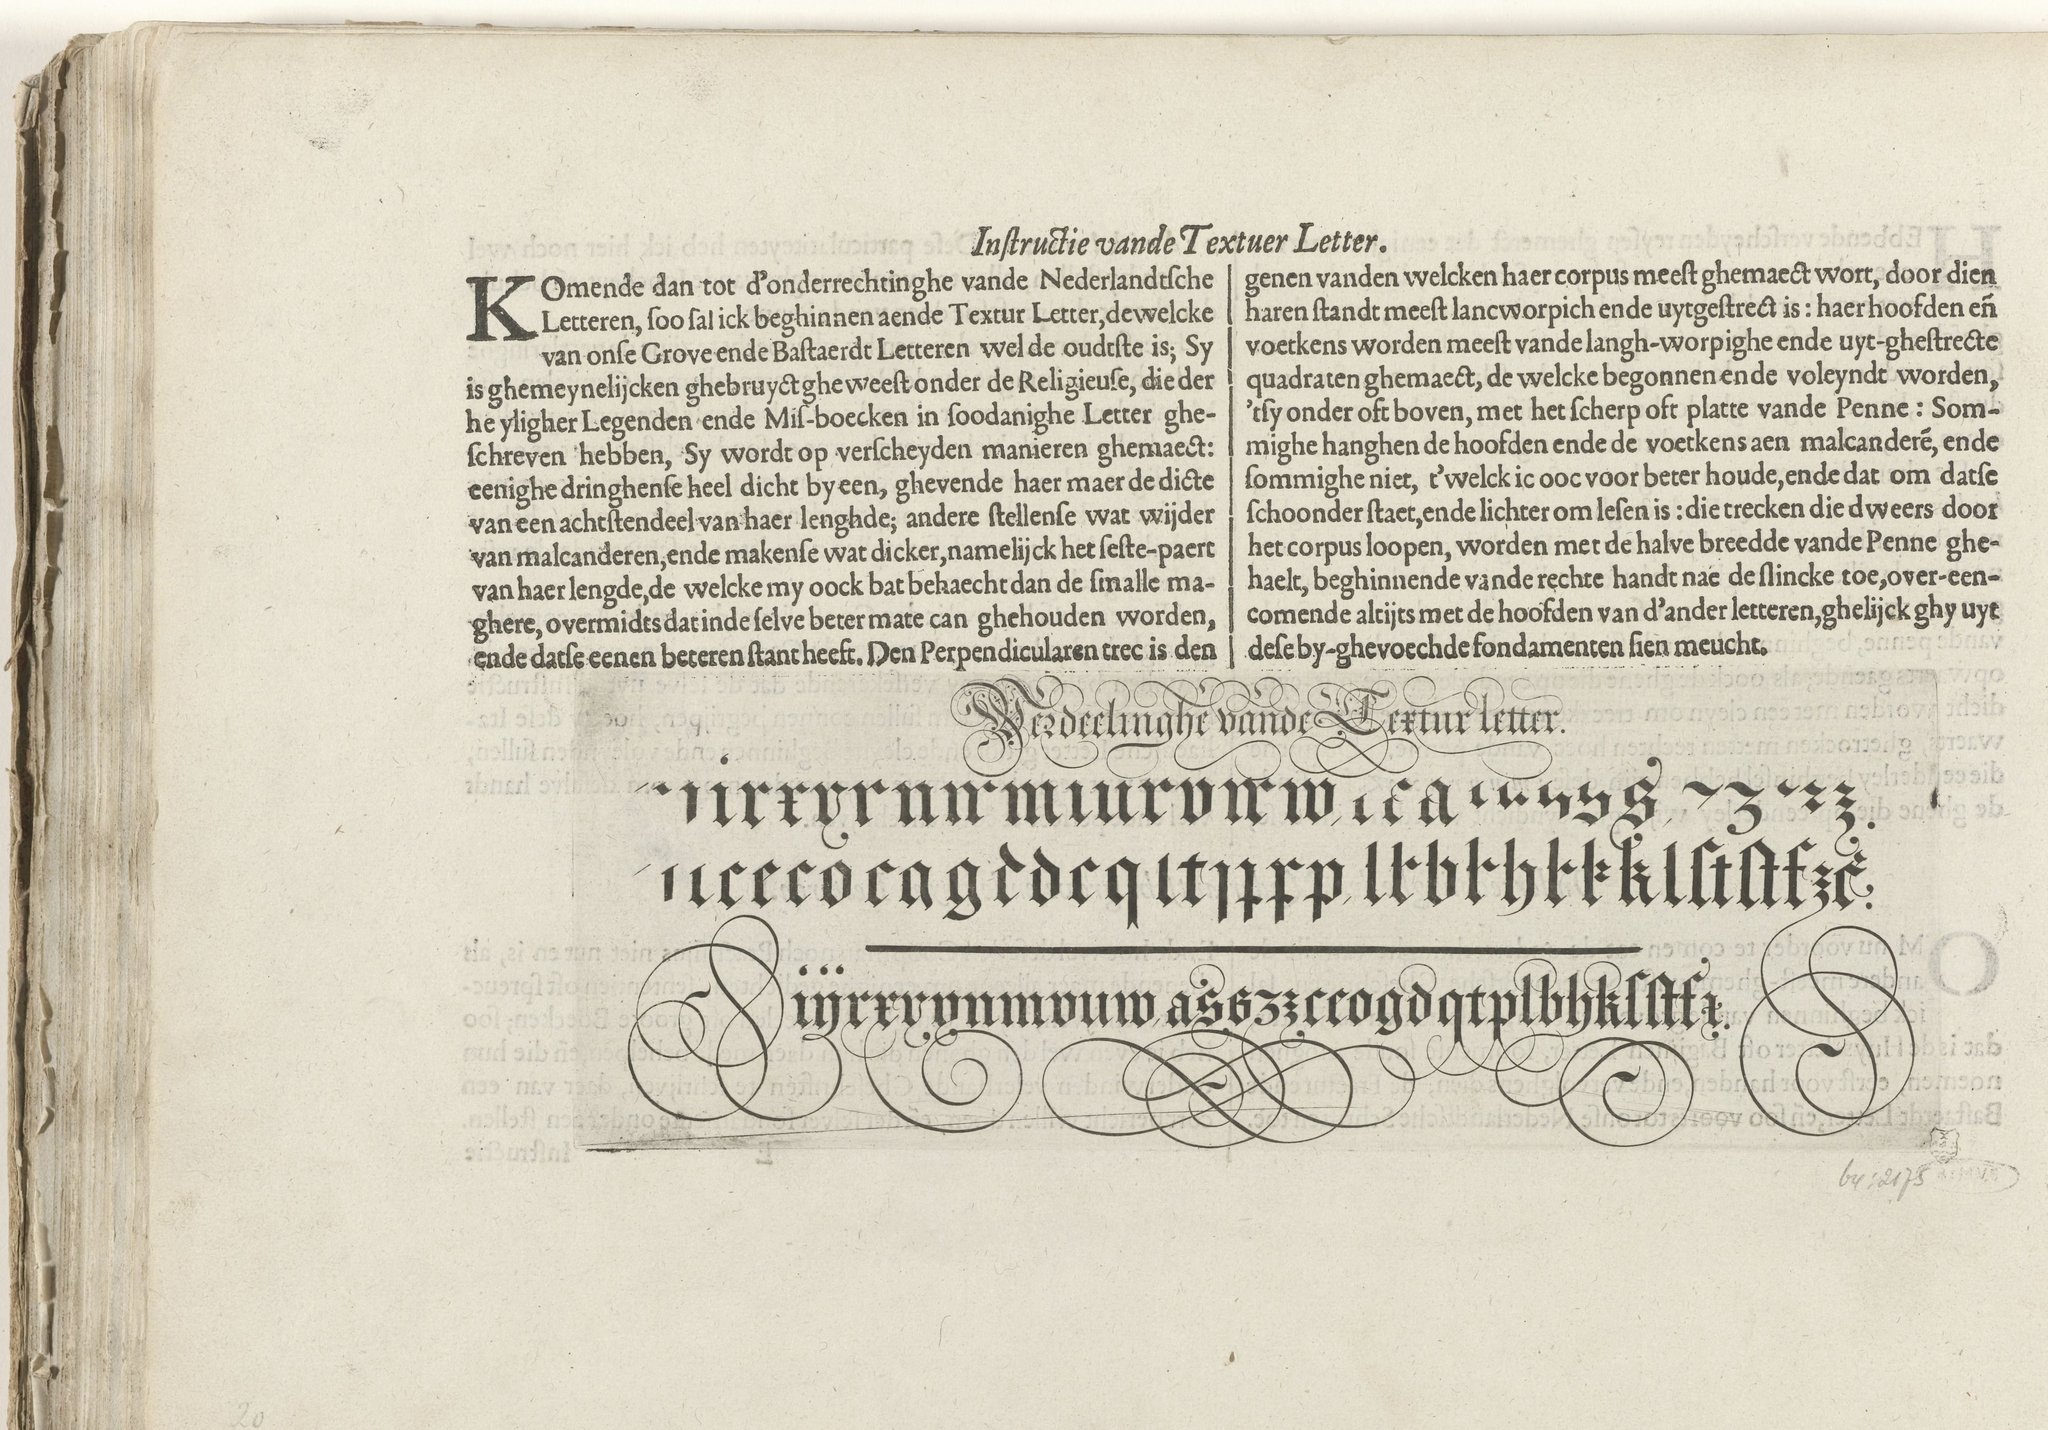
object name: text sheet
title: Spieghel der schrijfkonste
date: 1605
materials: paper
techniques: engraving, letterpress printing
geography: amsterdam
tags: calligraphy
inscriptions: collector's mark: Lugt 2228, collector's mark: Lugt 2760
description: Folio E1v met een beschrijving en een schrijfvoorbeeld van de Textur Letter, getiteld: Verdeelinghe vande Textur letter. De tekst vangt aan met een kleine initiaal K. Het blad maakt deel uit van een album.